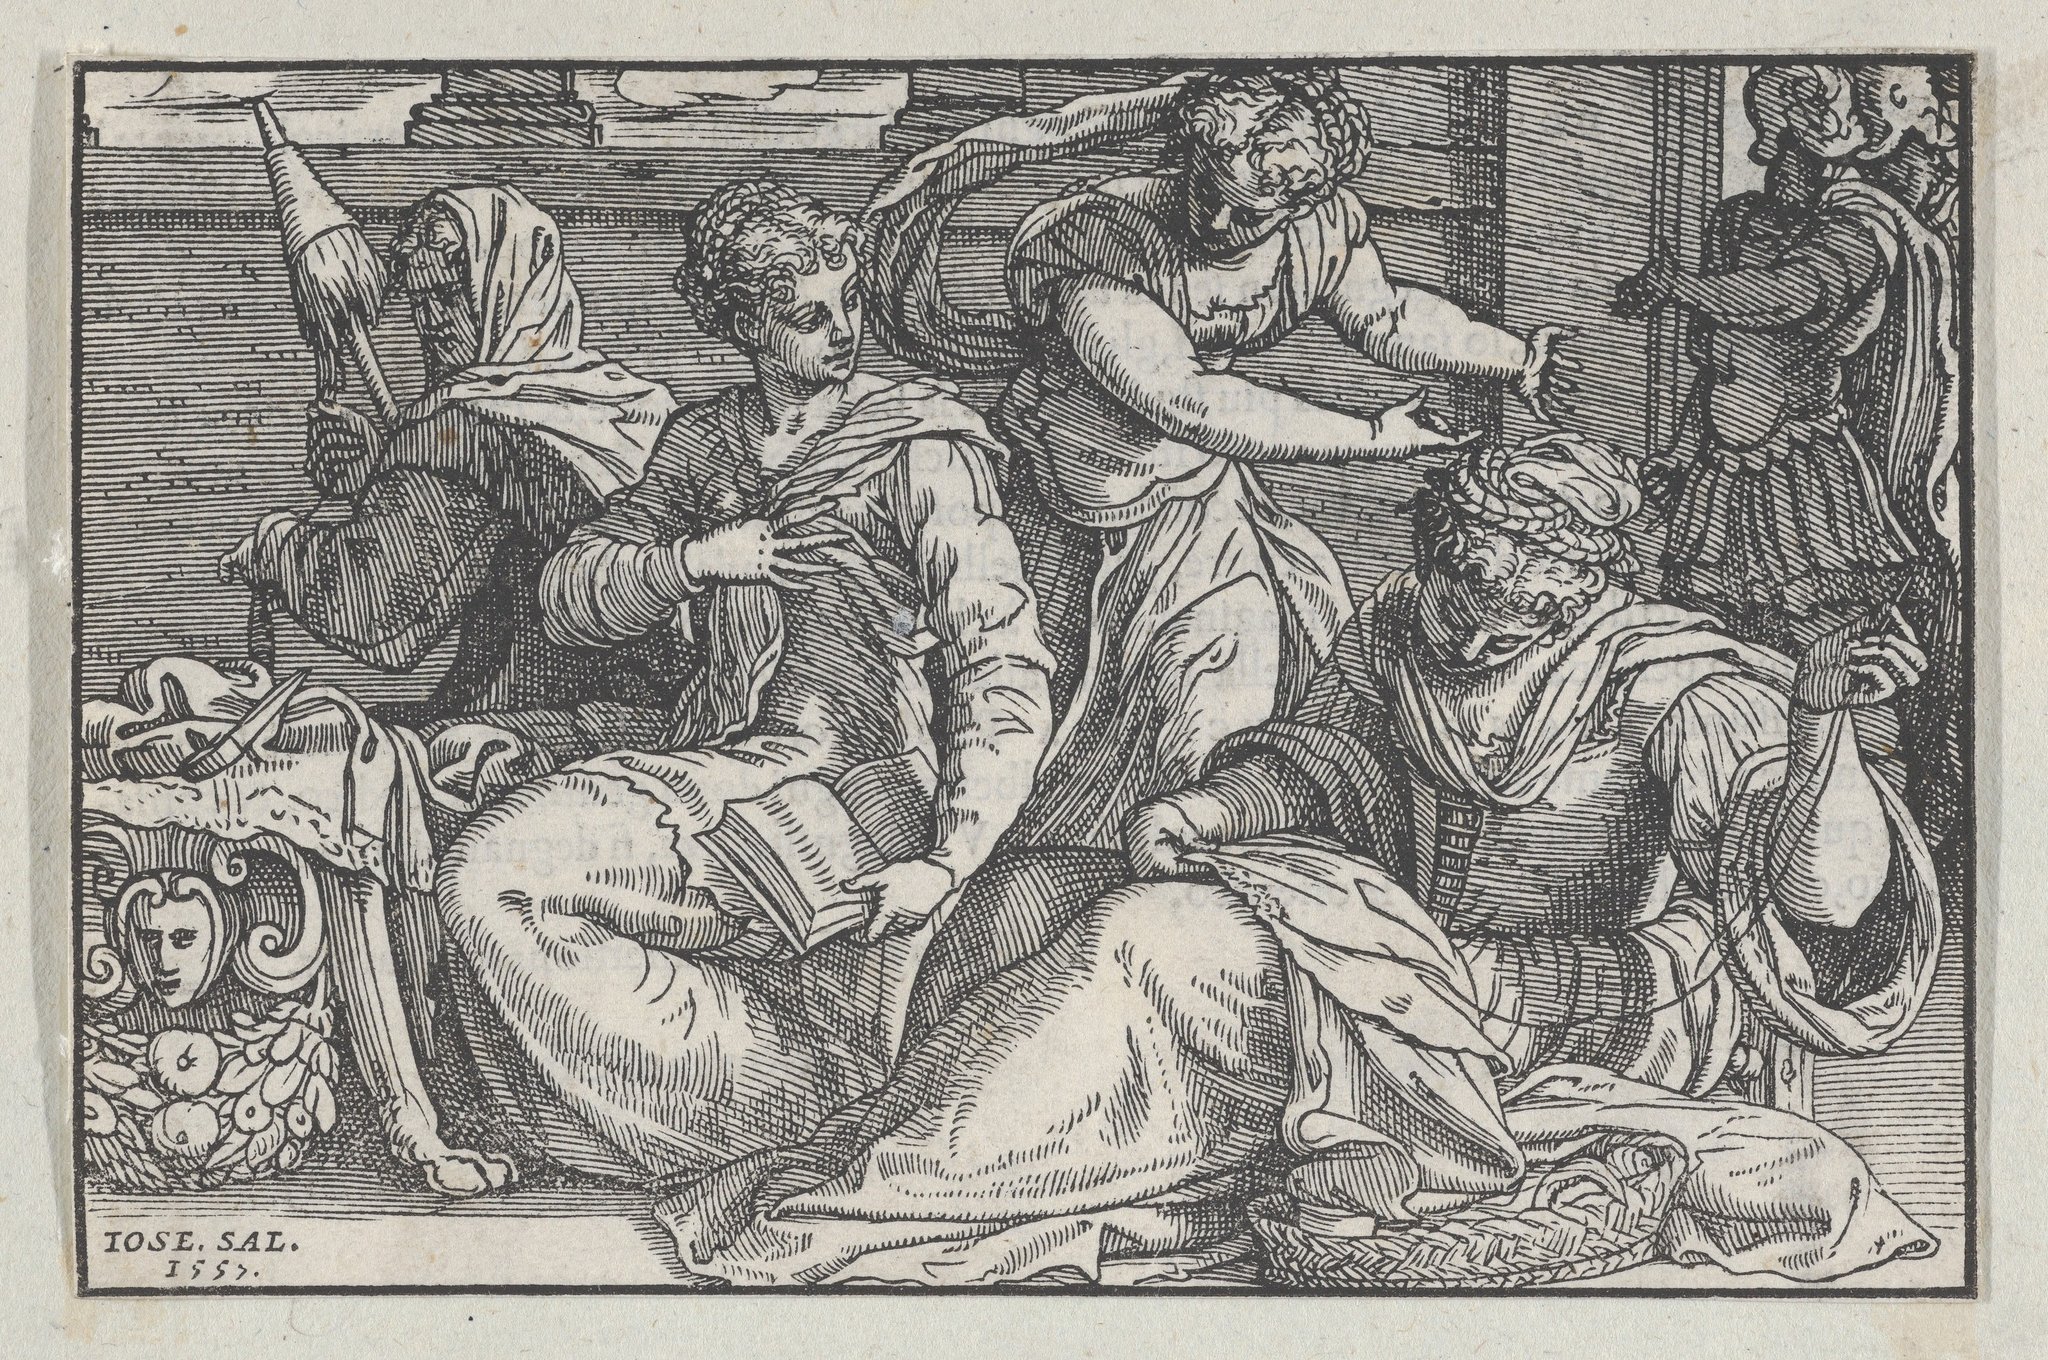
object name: print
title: Lucretia instructing her daughters in needlework from Giovanni Ostaus's, La vera perfettione del disegno di varie sorte di recami (Venice, 1557)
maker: giuseppe salviati (giuseppe porta, called il salviati)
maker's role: artist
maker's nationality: italian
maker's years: 1515-1580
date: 1557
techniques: woodcut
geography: venice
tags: women,working